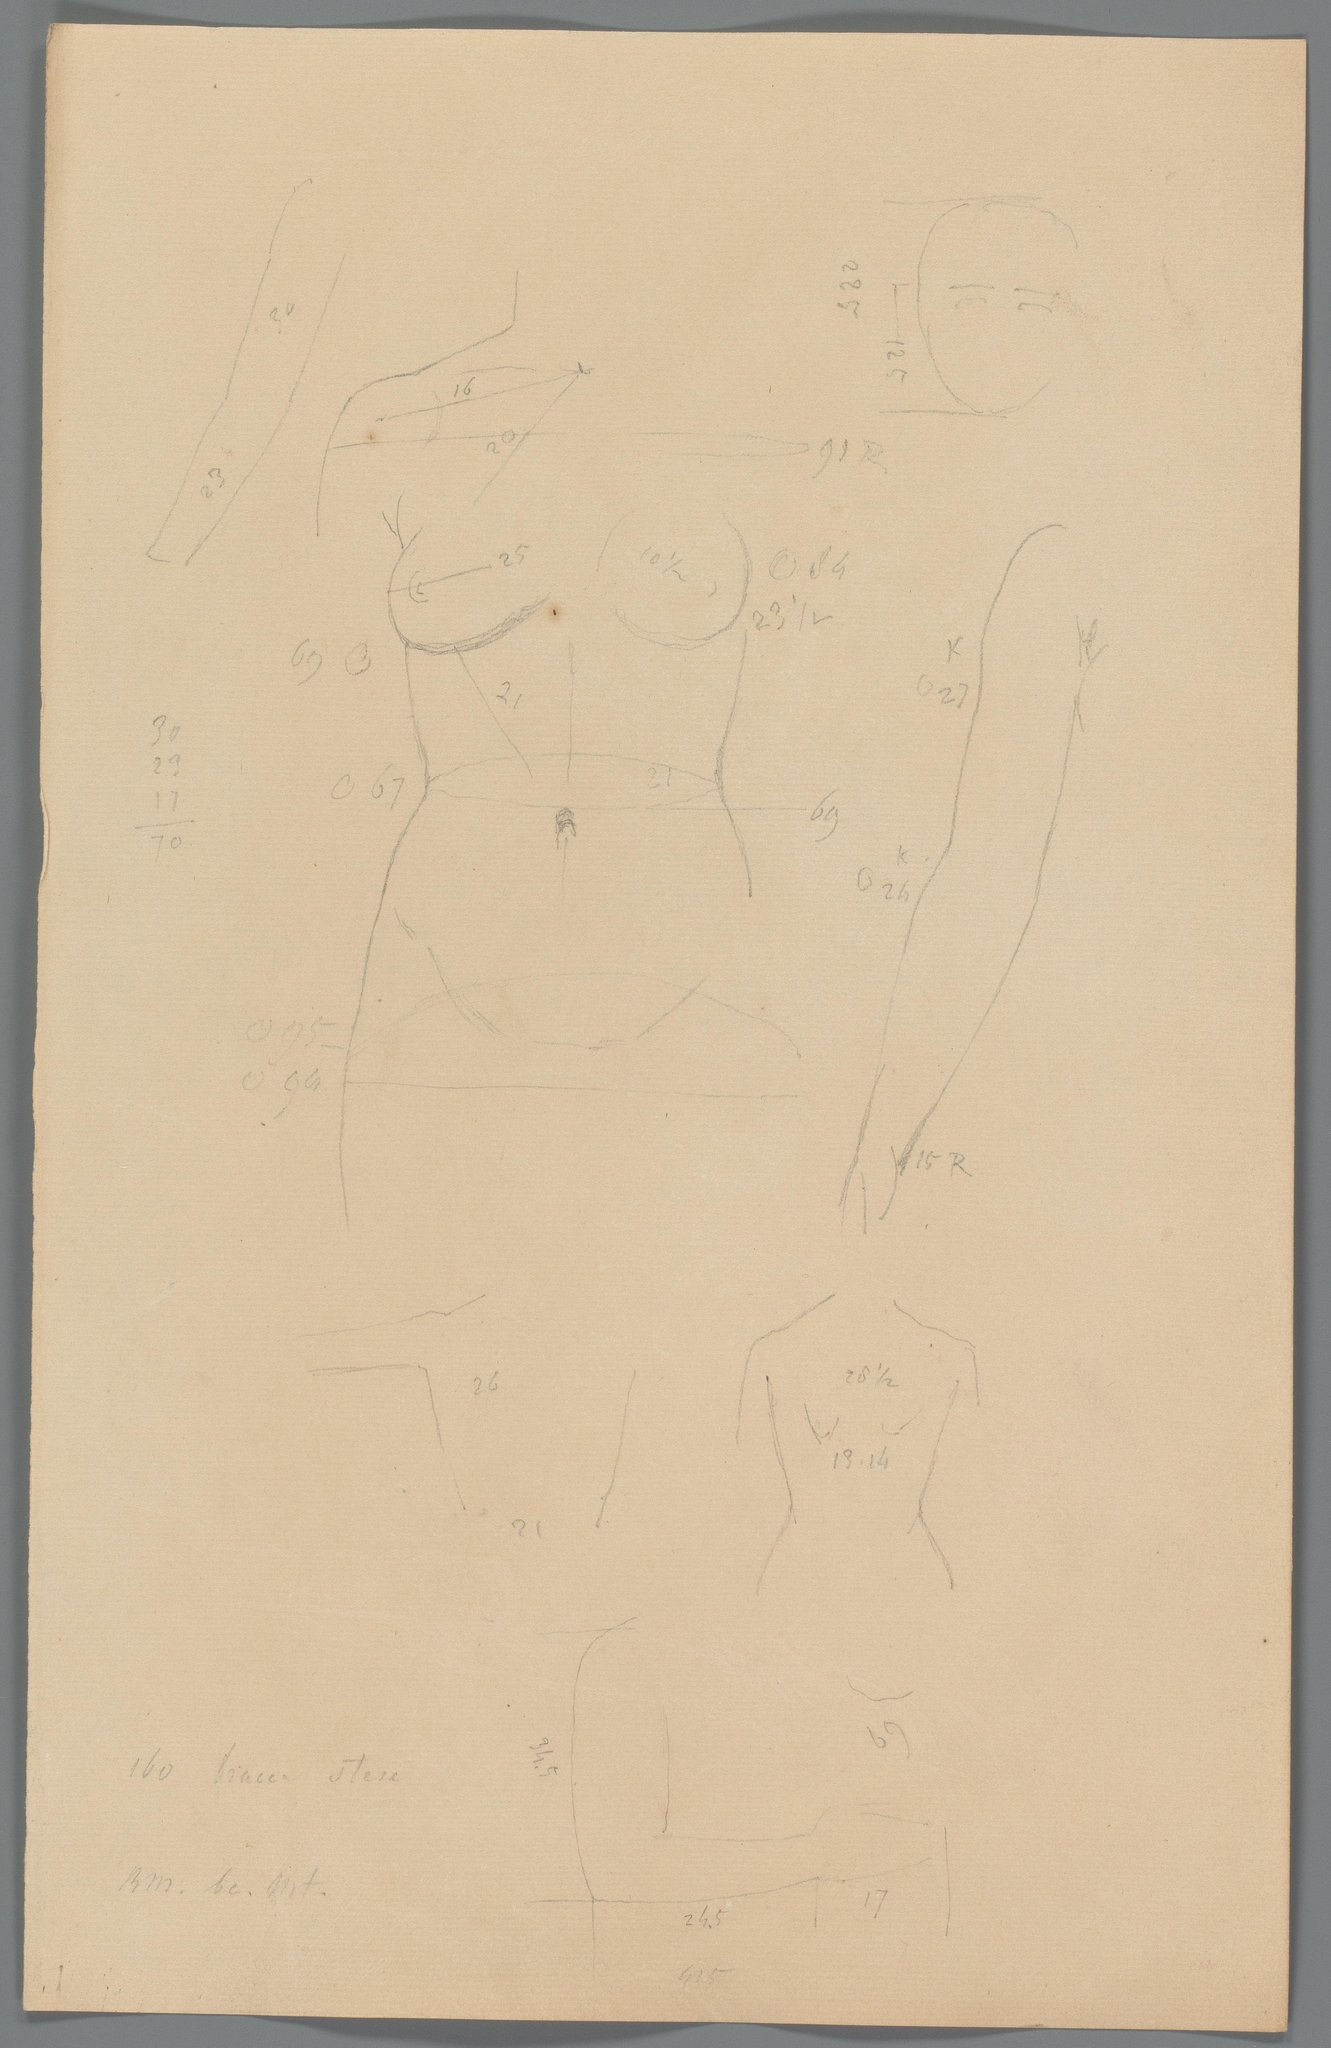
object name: drawing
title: Proportiestudie van een vrouw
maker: jacobus everhardus josephus van den berg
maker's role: draughtsman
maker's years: 1802-1861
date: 1812-1861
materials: paper, pencil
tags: standing figure (canon, proportions) - aa - female human figure, human figure of ideal proportions, e.g. academic nude - aa - female human figure